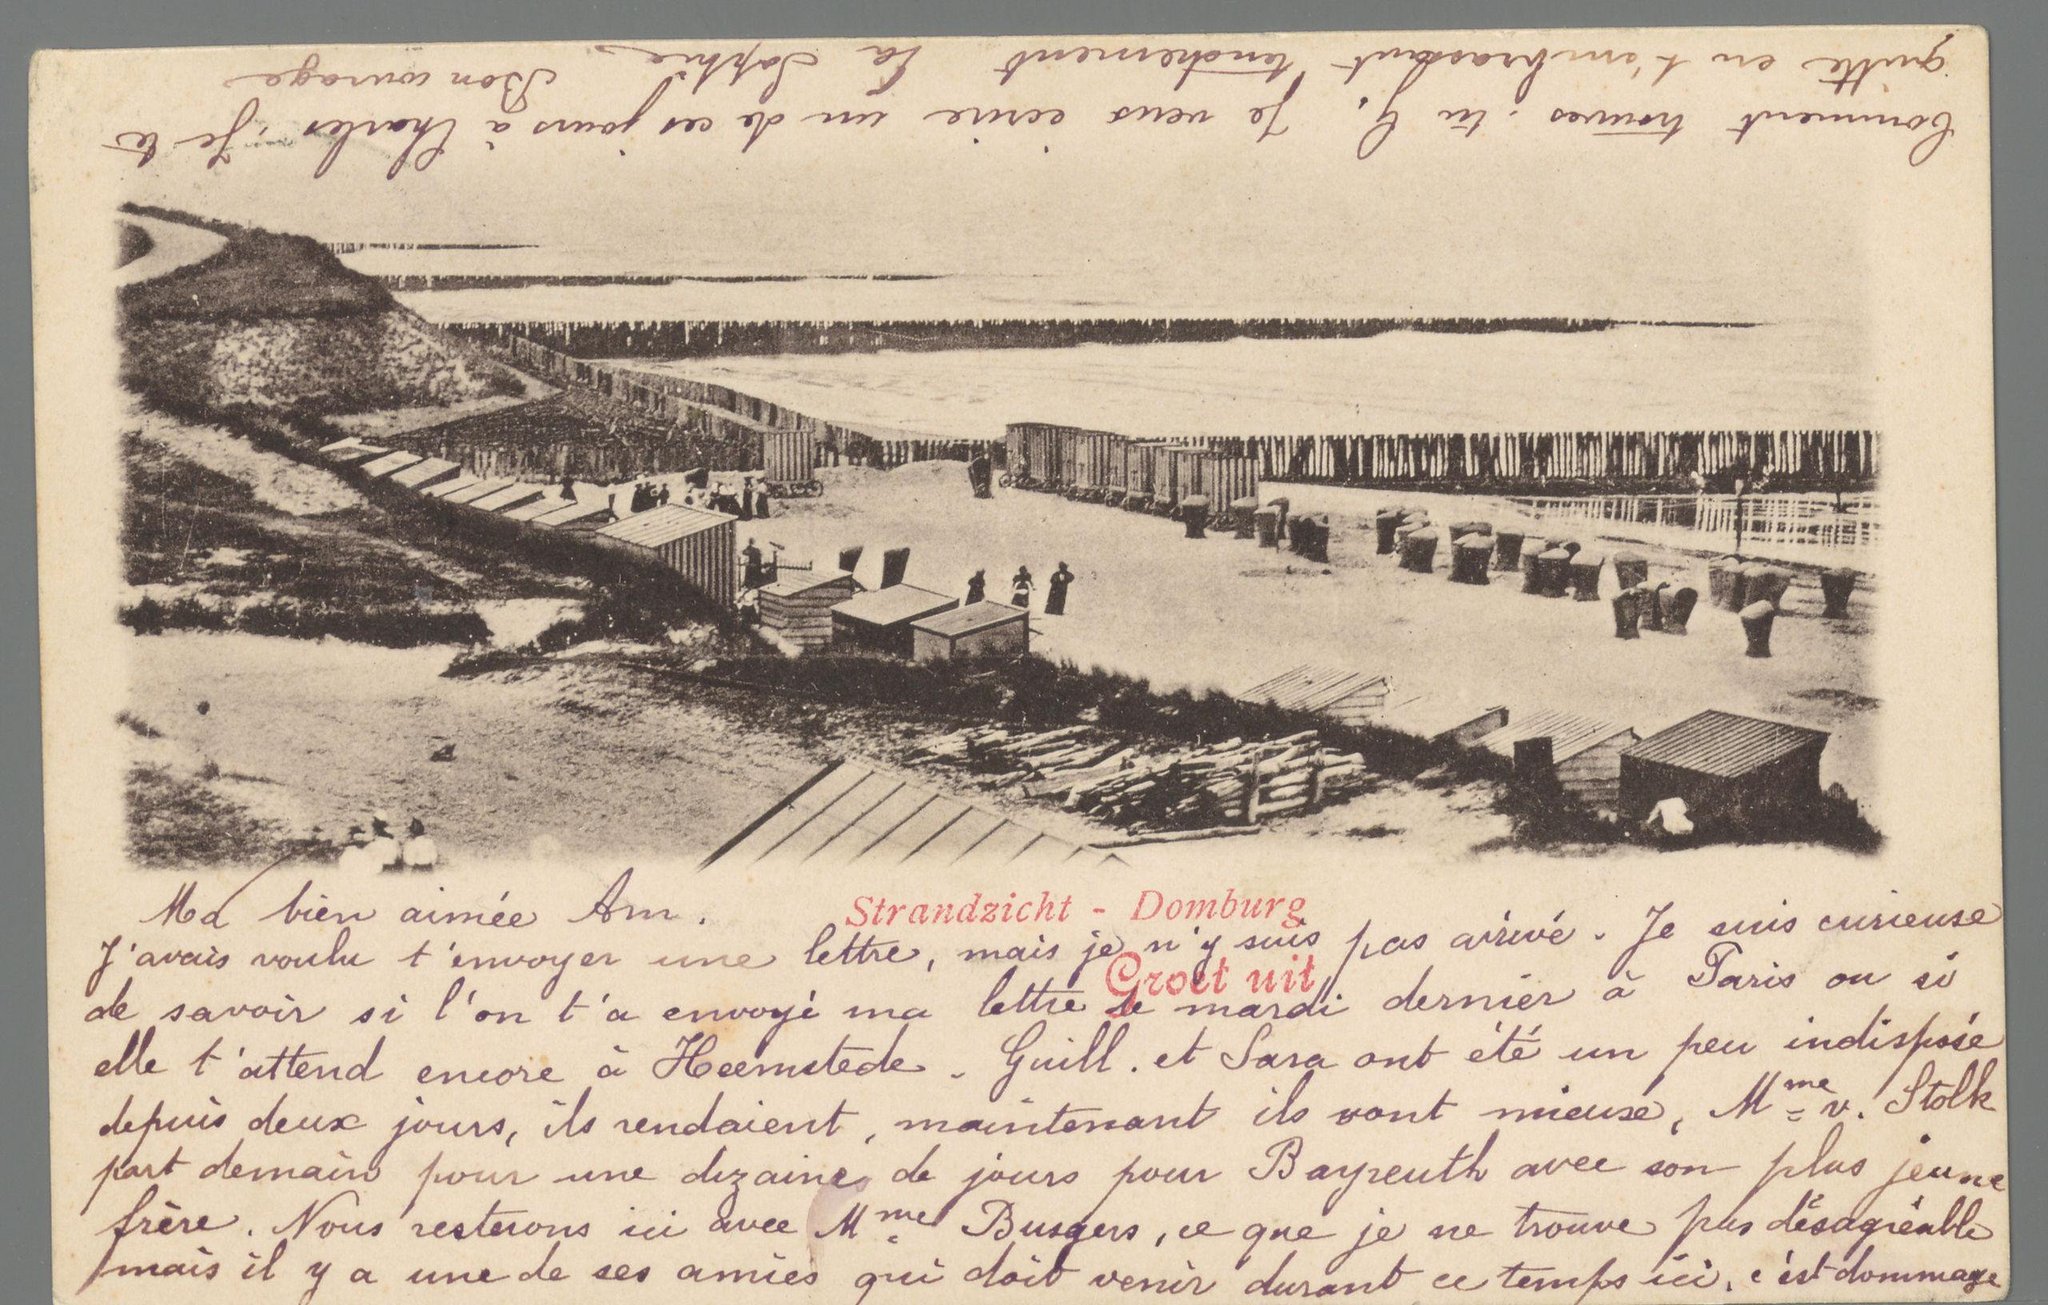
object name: ansichtkaart, prentbriefkaart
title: Strandgezicht - Domburg. Groet uit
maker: Anonymous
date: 1895-1901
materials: cardboard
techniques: photograph, writing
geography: domburg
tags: beach (as place of recreation), sea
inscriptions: postage stamp